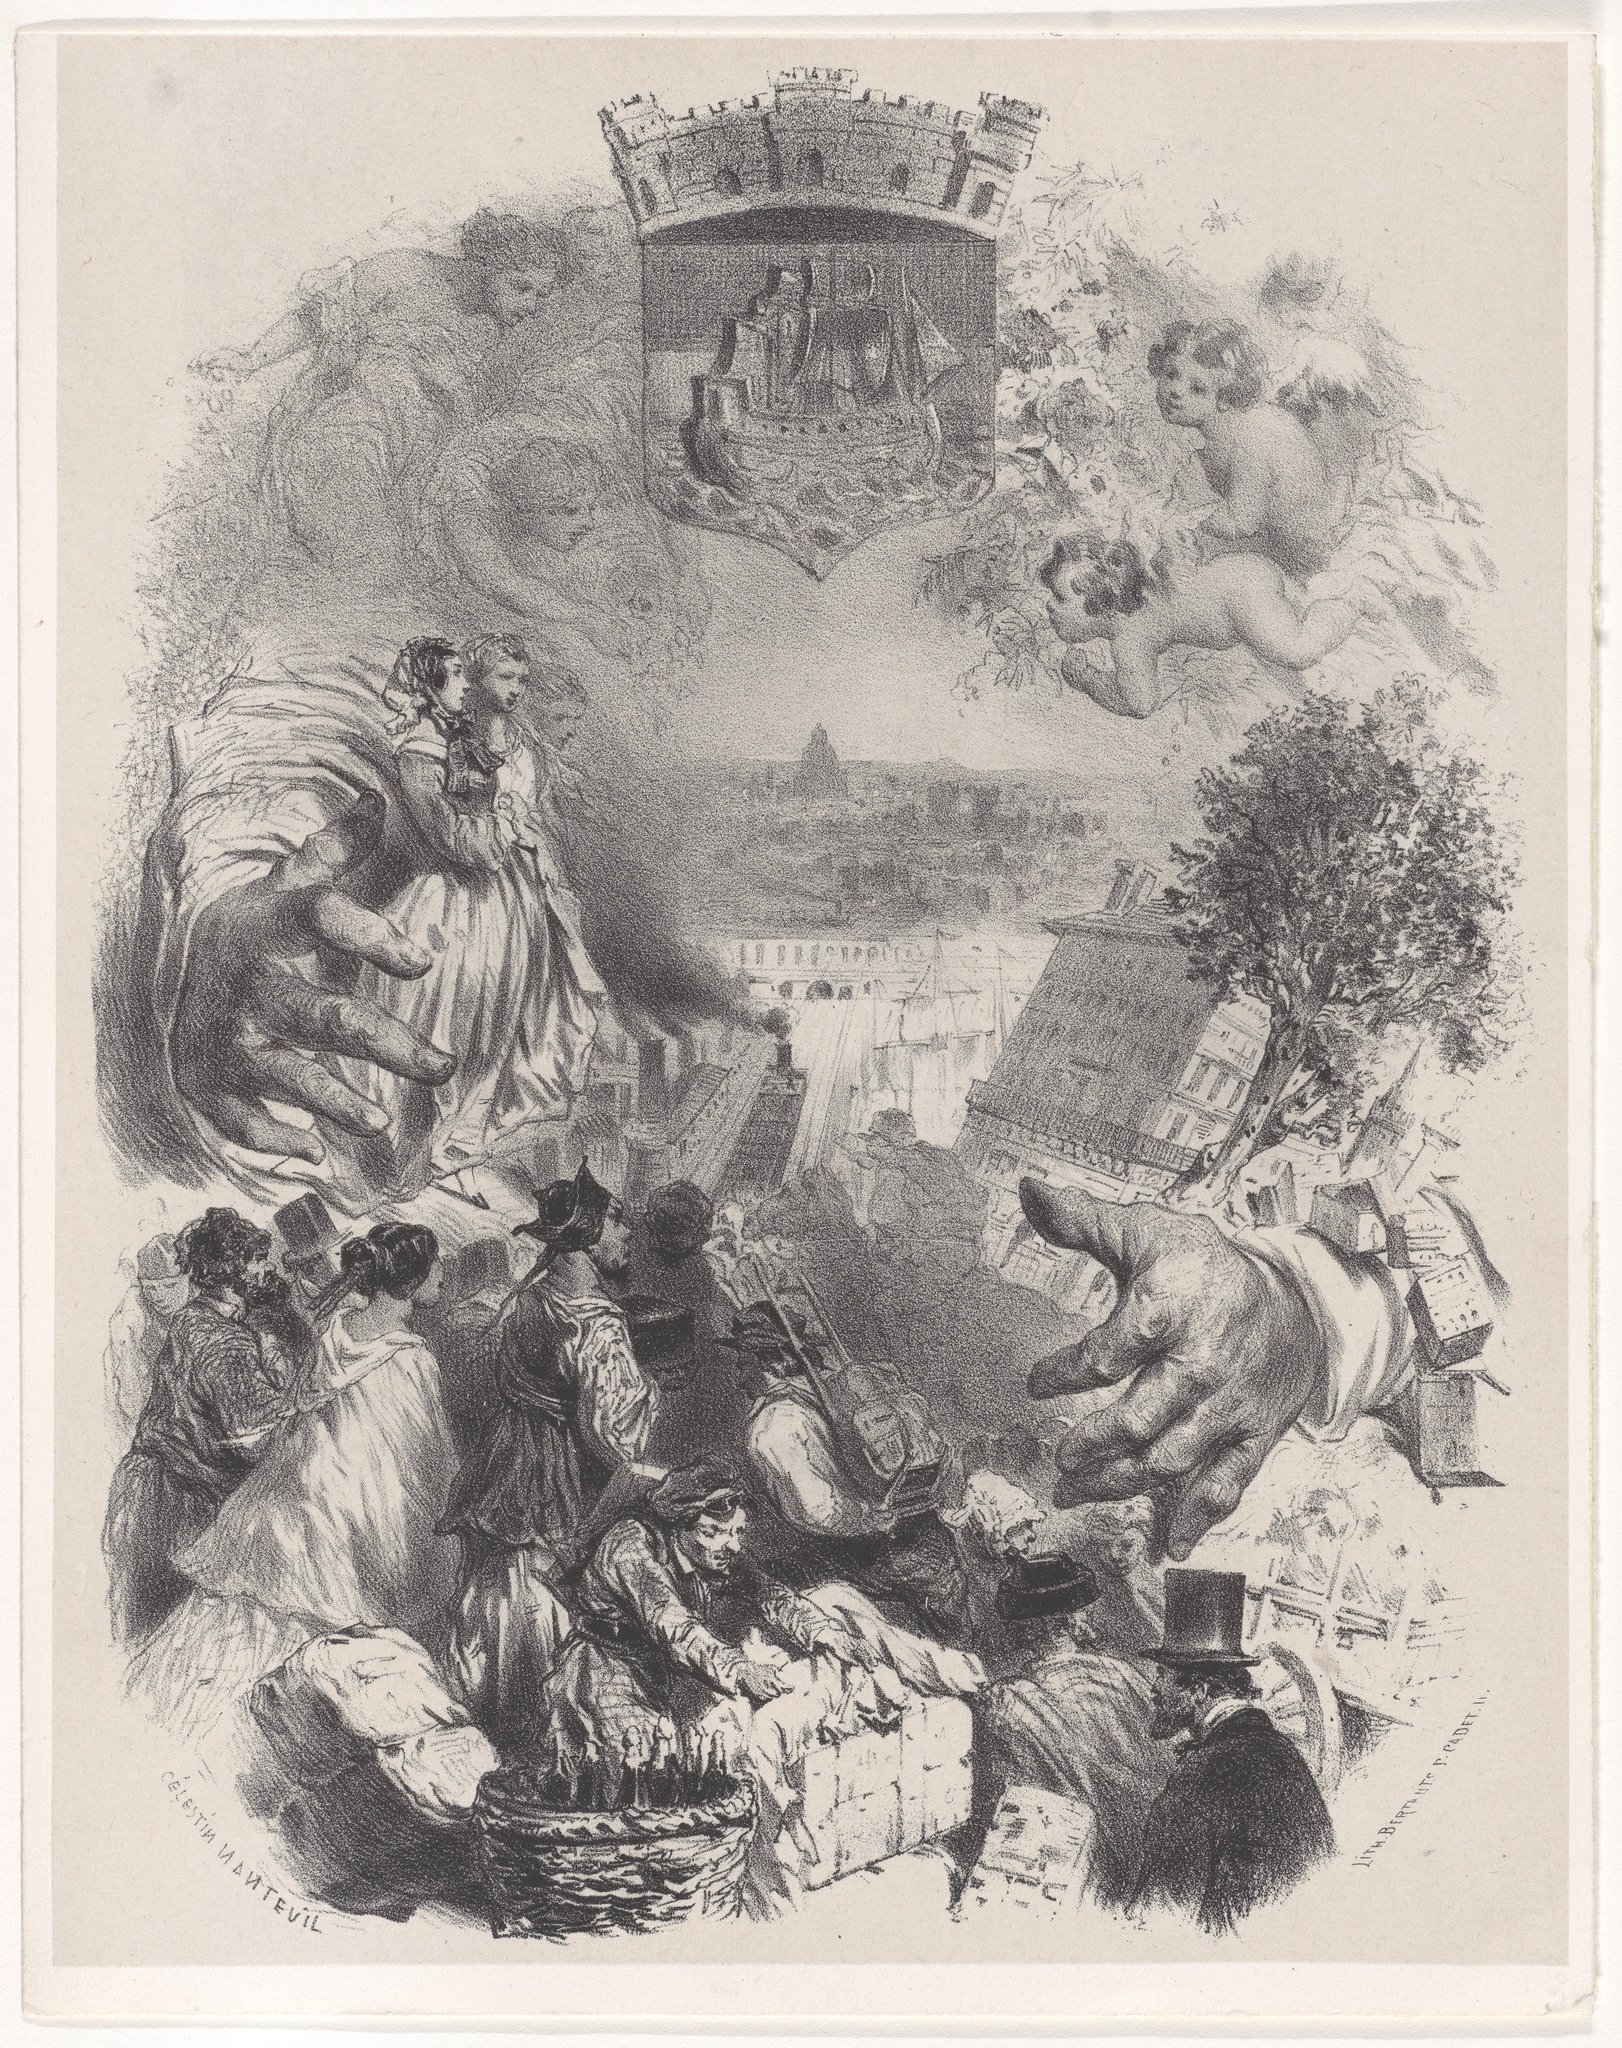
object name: print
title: Title Page for Les Artistes Anciens & Modernes, Vol. IX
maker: célestin nanteuil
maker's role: artist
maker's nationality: french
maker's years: 1813-1873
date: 1848-1862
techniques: lithograph